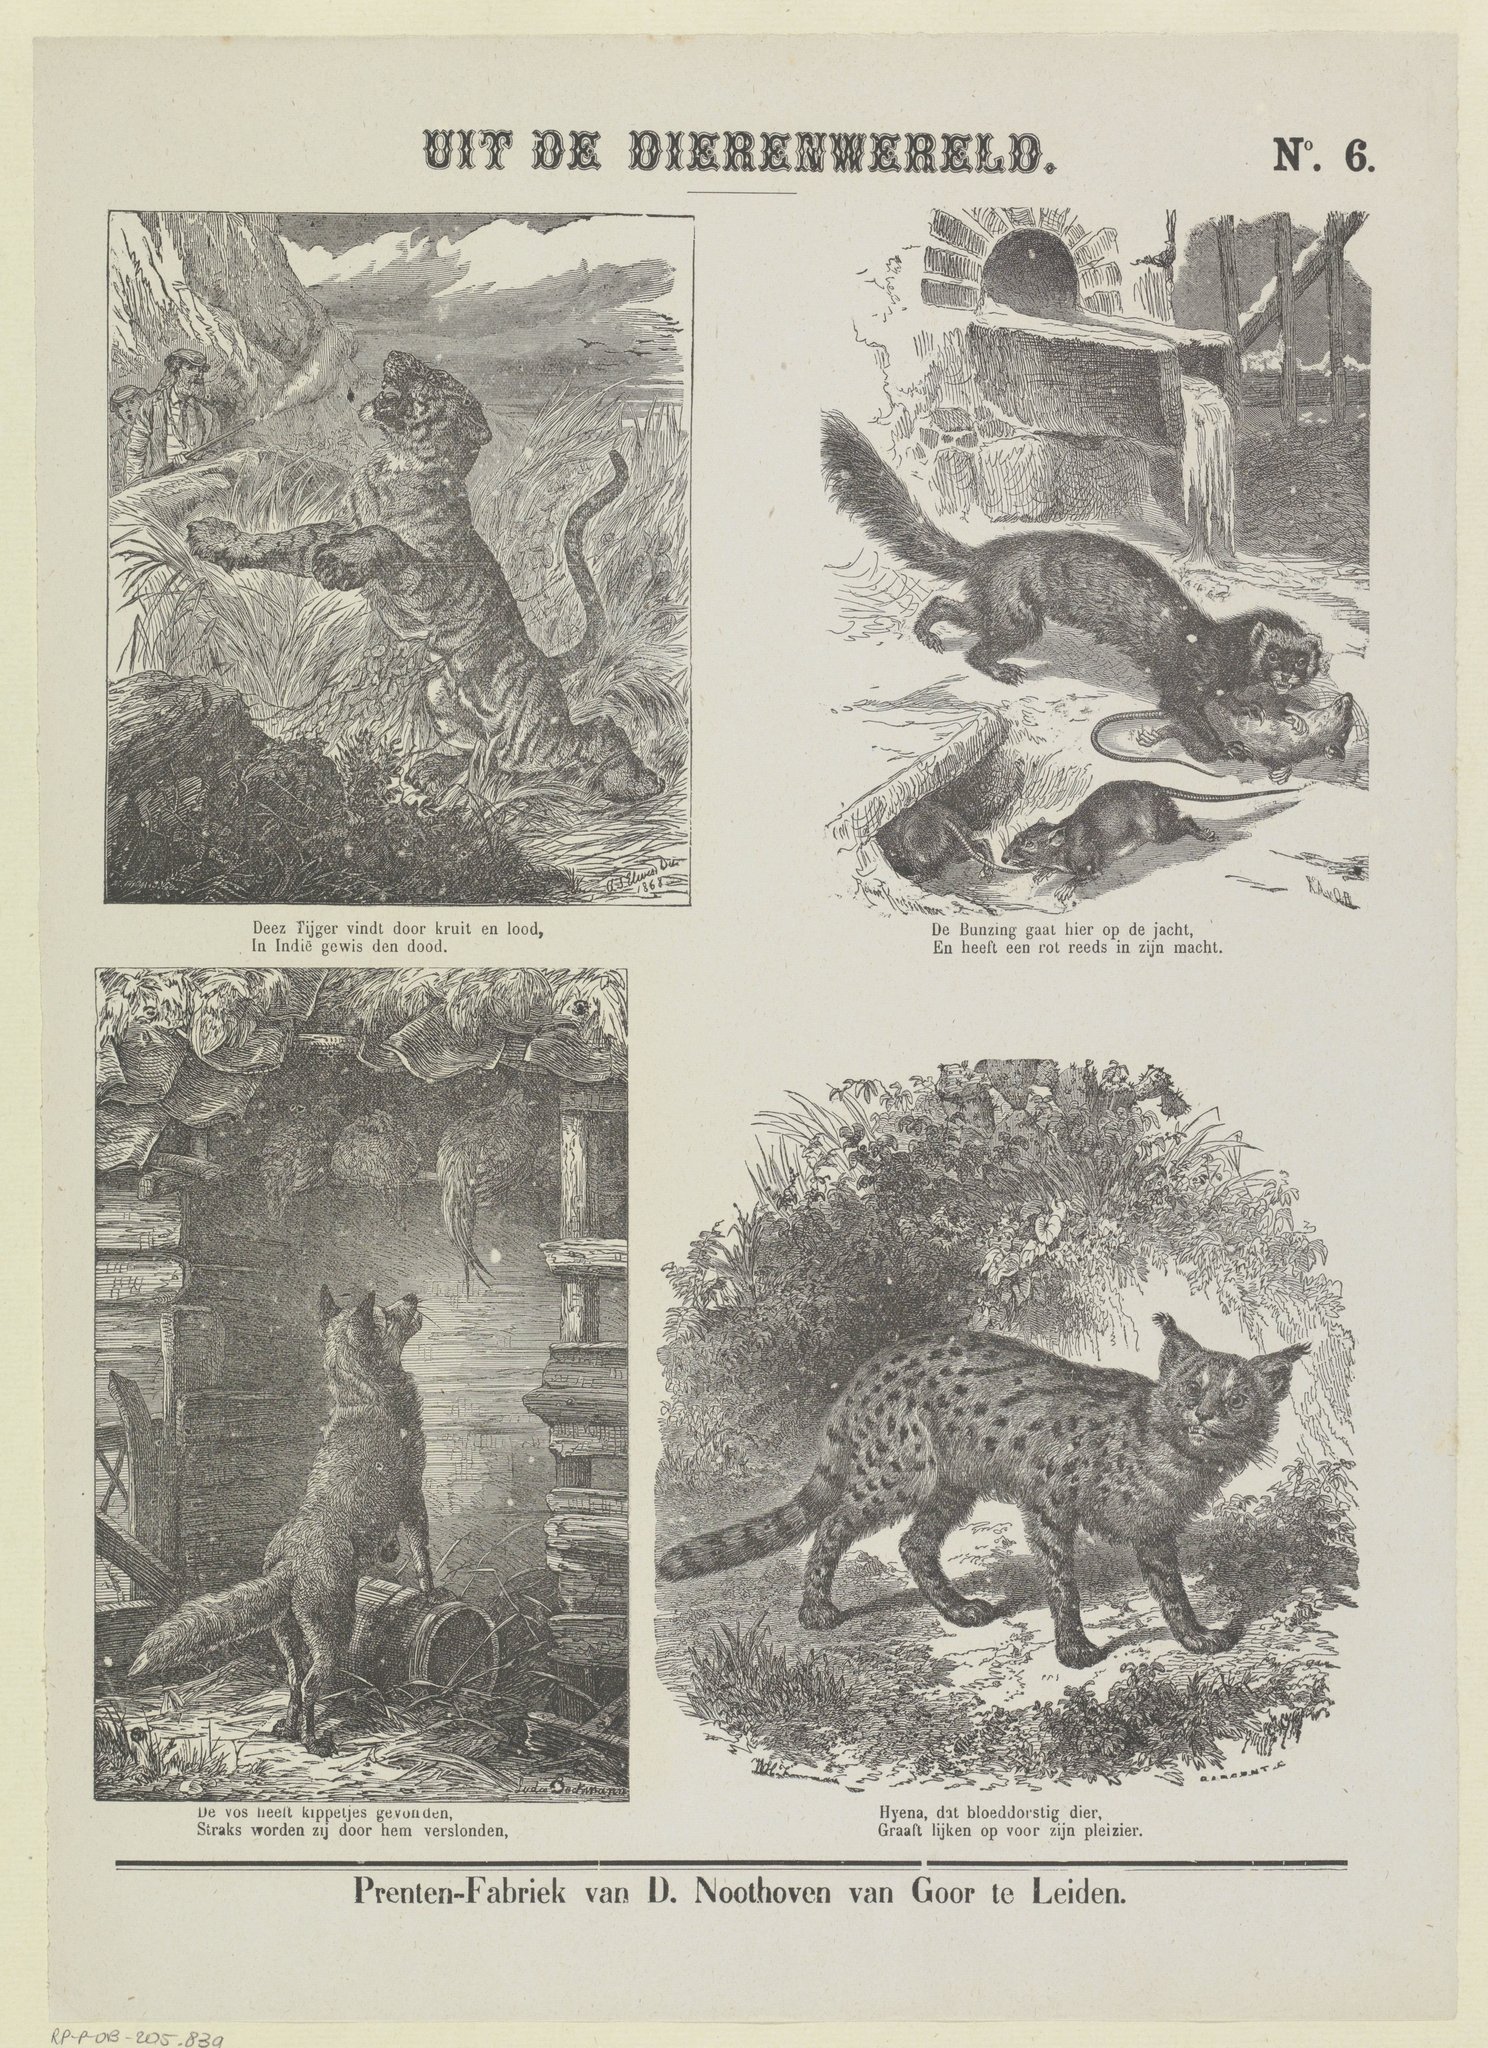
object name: print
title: Uit de dierenwereld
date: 1850-1881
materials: paper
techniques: letterpress printing, engraving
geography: leiden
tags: beasts of prey, predatory animals: tiger, animals, beasts of prey, predatory animals: polecat, beasts of prey, predatory animals: lynx, beasts of prey, predatory animals: fox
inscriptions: collector's mark: Lugt 2760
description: Blad met 4 voorstellingen van dieren: een tijger, een bunzing, een vos en een lynx (hier een hyena genoemd). Onder elke voorstelling een tweeregelig vers. Genummerd rechtsboven: No. 6.